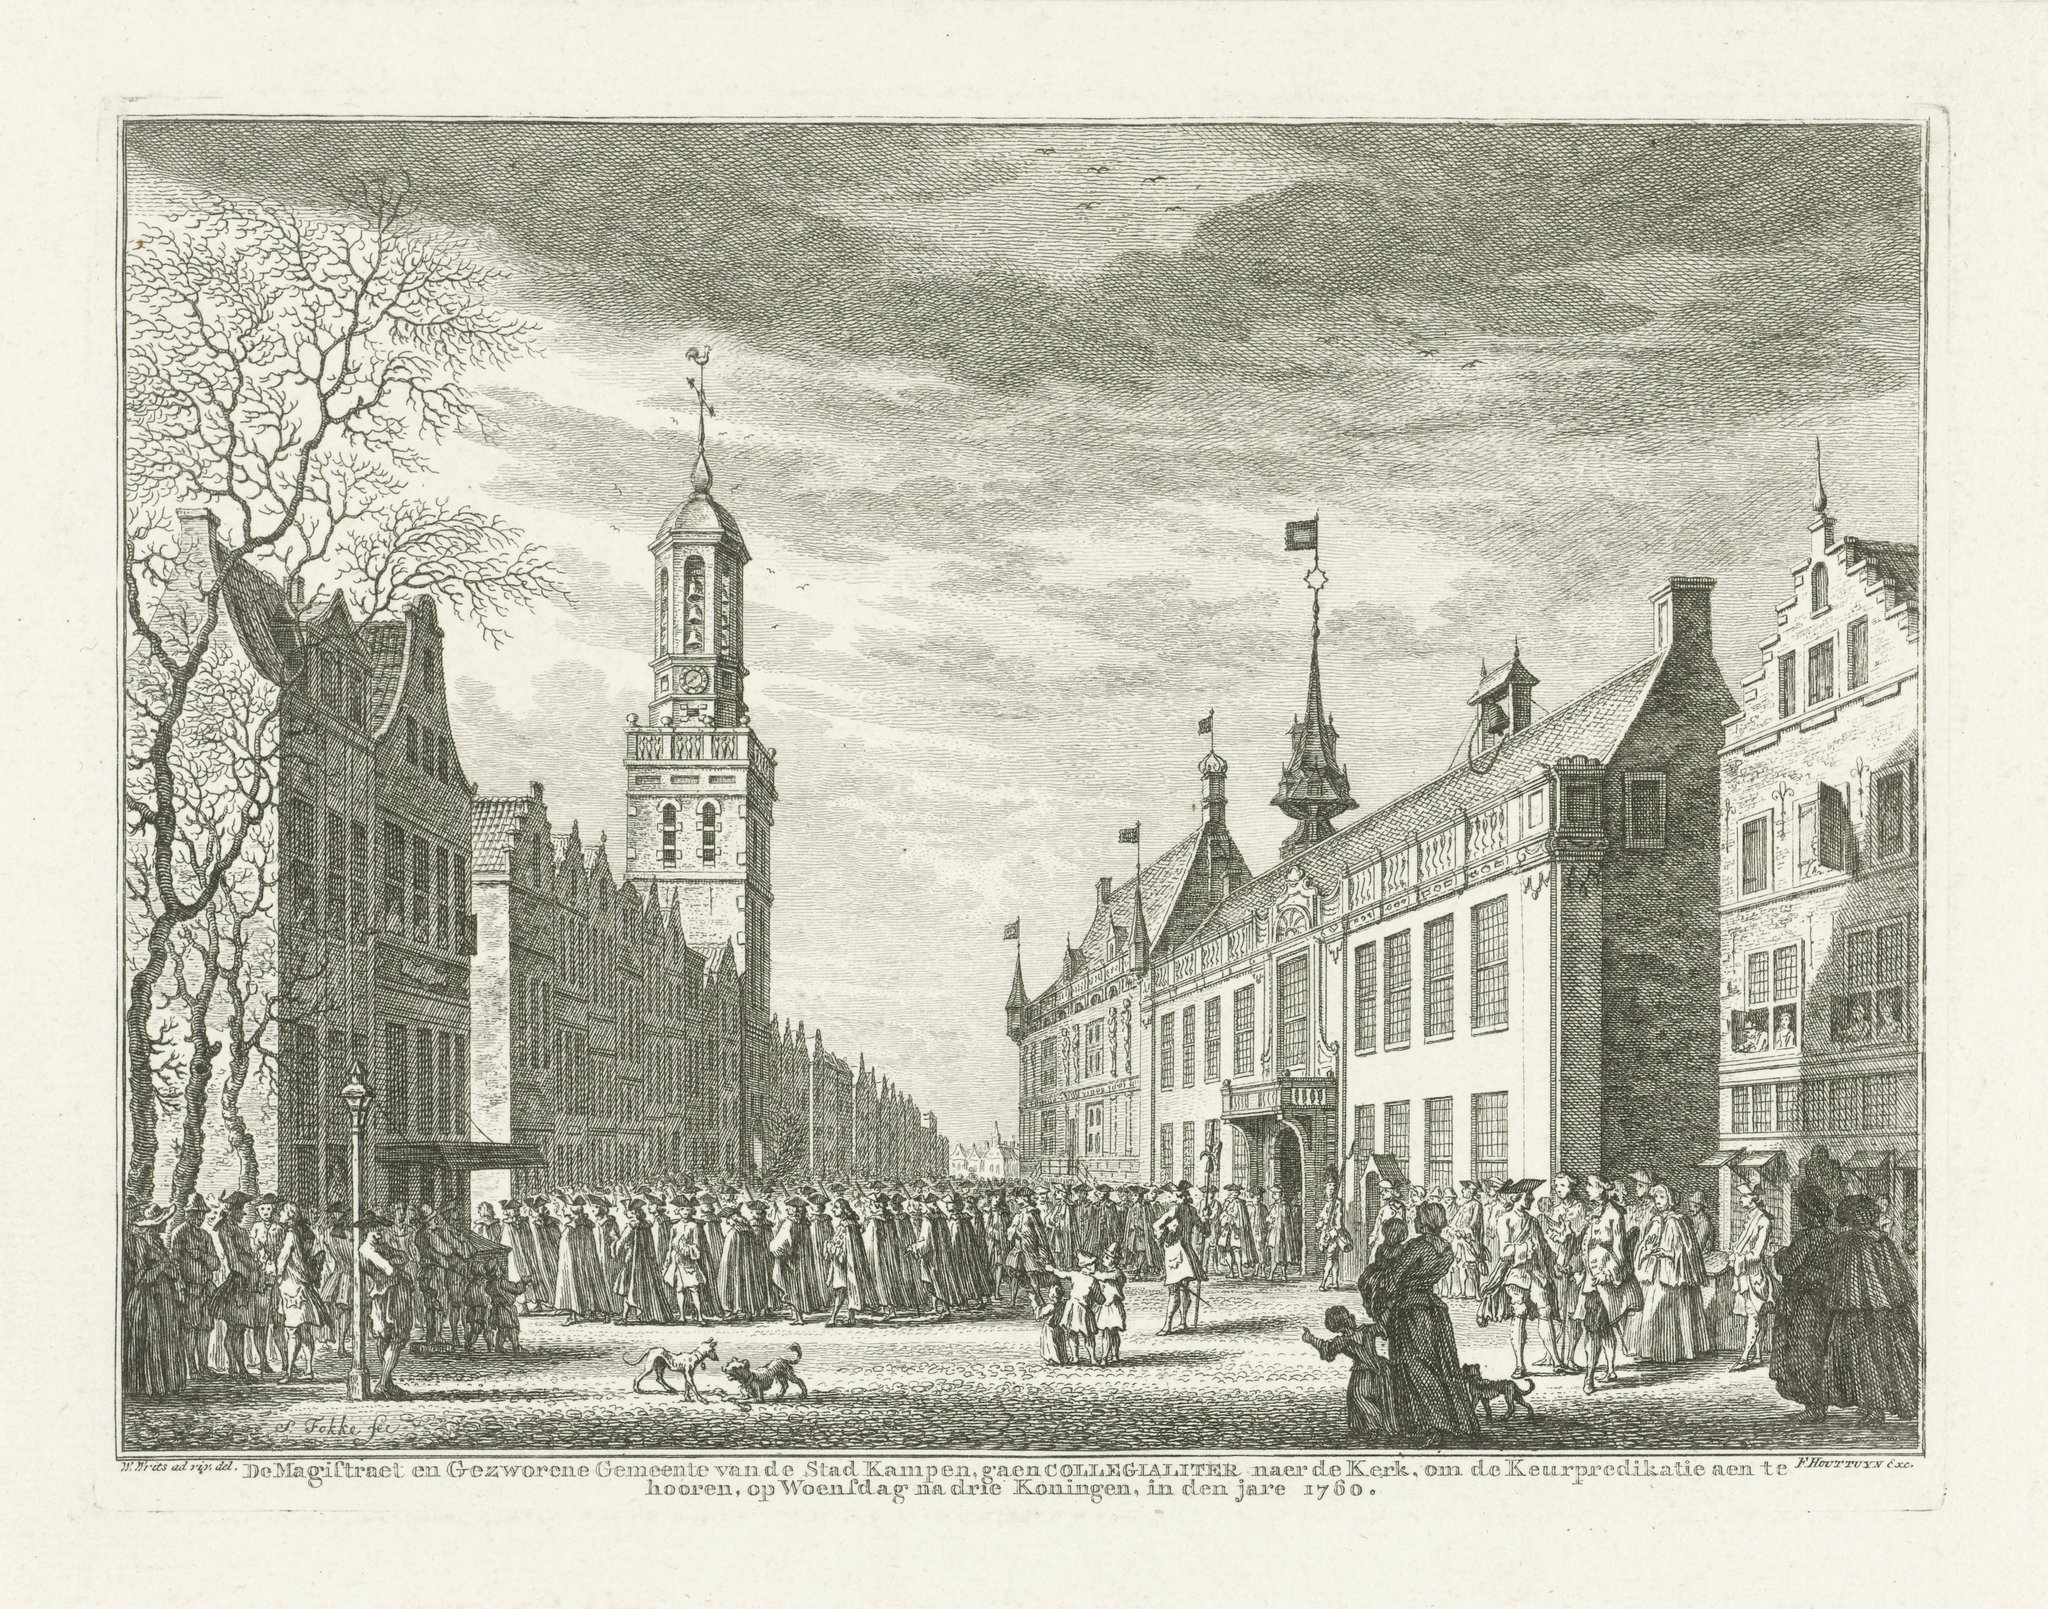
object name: print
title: De Magistraet en Gezworene Gemeente van de Stad Kampen, gaen Collegialiter naer de Kerk, om de Keurpredikatie aen te hooren, op Woensdag na drie Koningen, in den jare 1760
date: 1760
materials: paper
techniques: engraving, etching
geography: northern netherlands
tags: kampen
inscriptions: collector's mark: Lugt 2228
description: Het stedelijk bestuur van de stad Kampen verlaat met de gezworen gemeente het stadhuis op weg naar de kerk voor de keurpredikatie, 9 januari 1760.